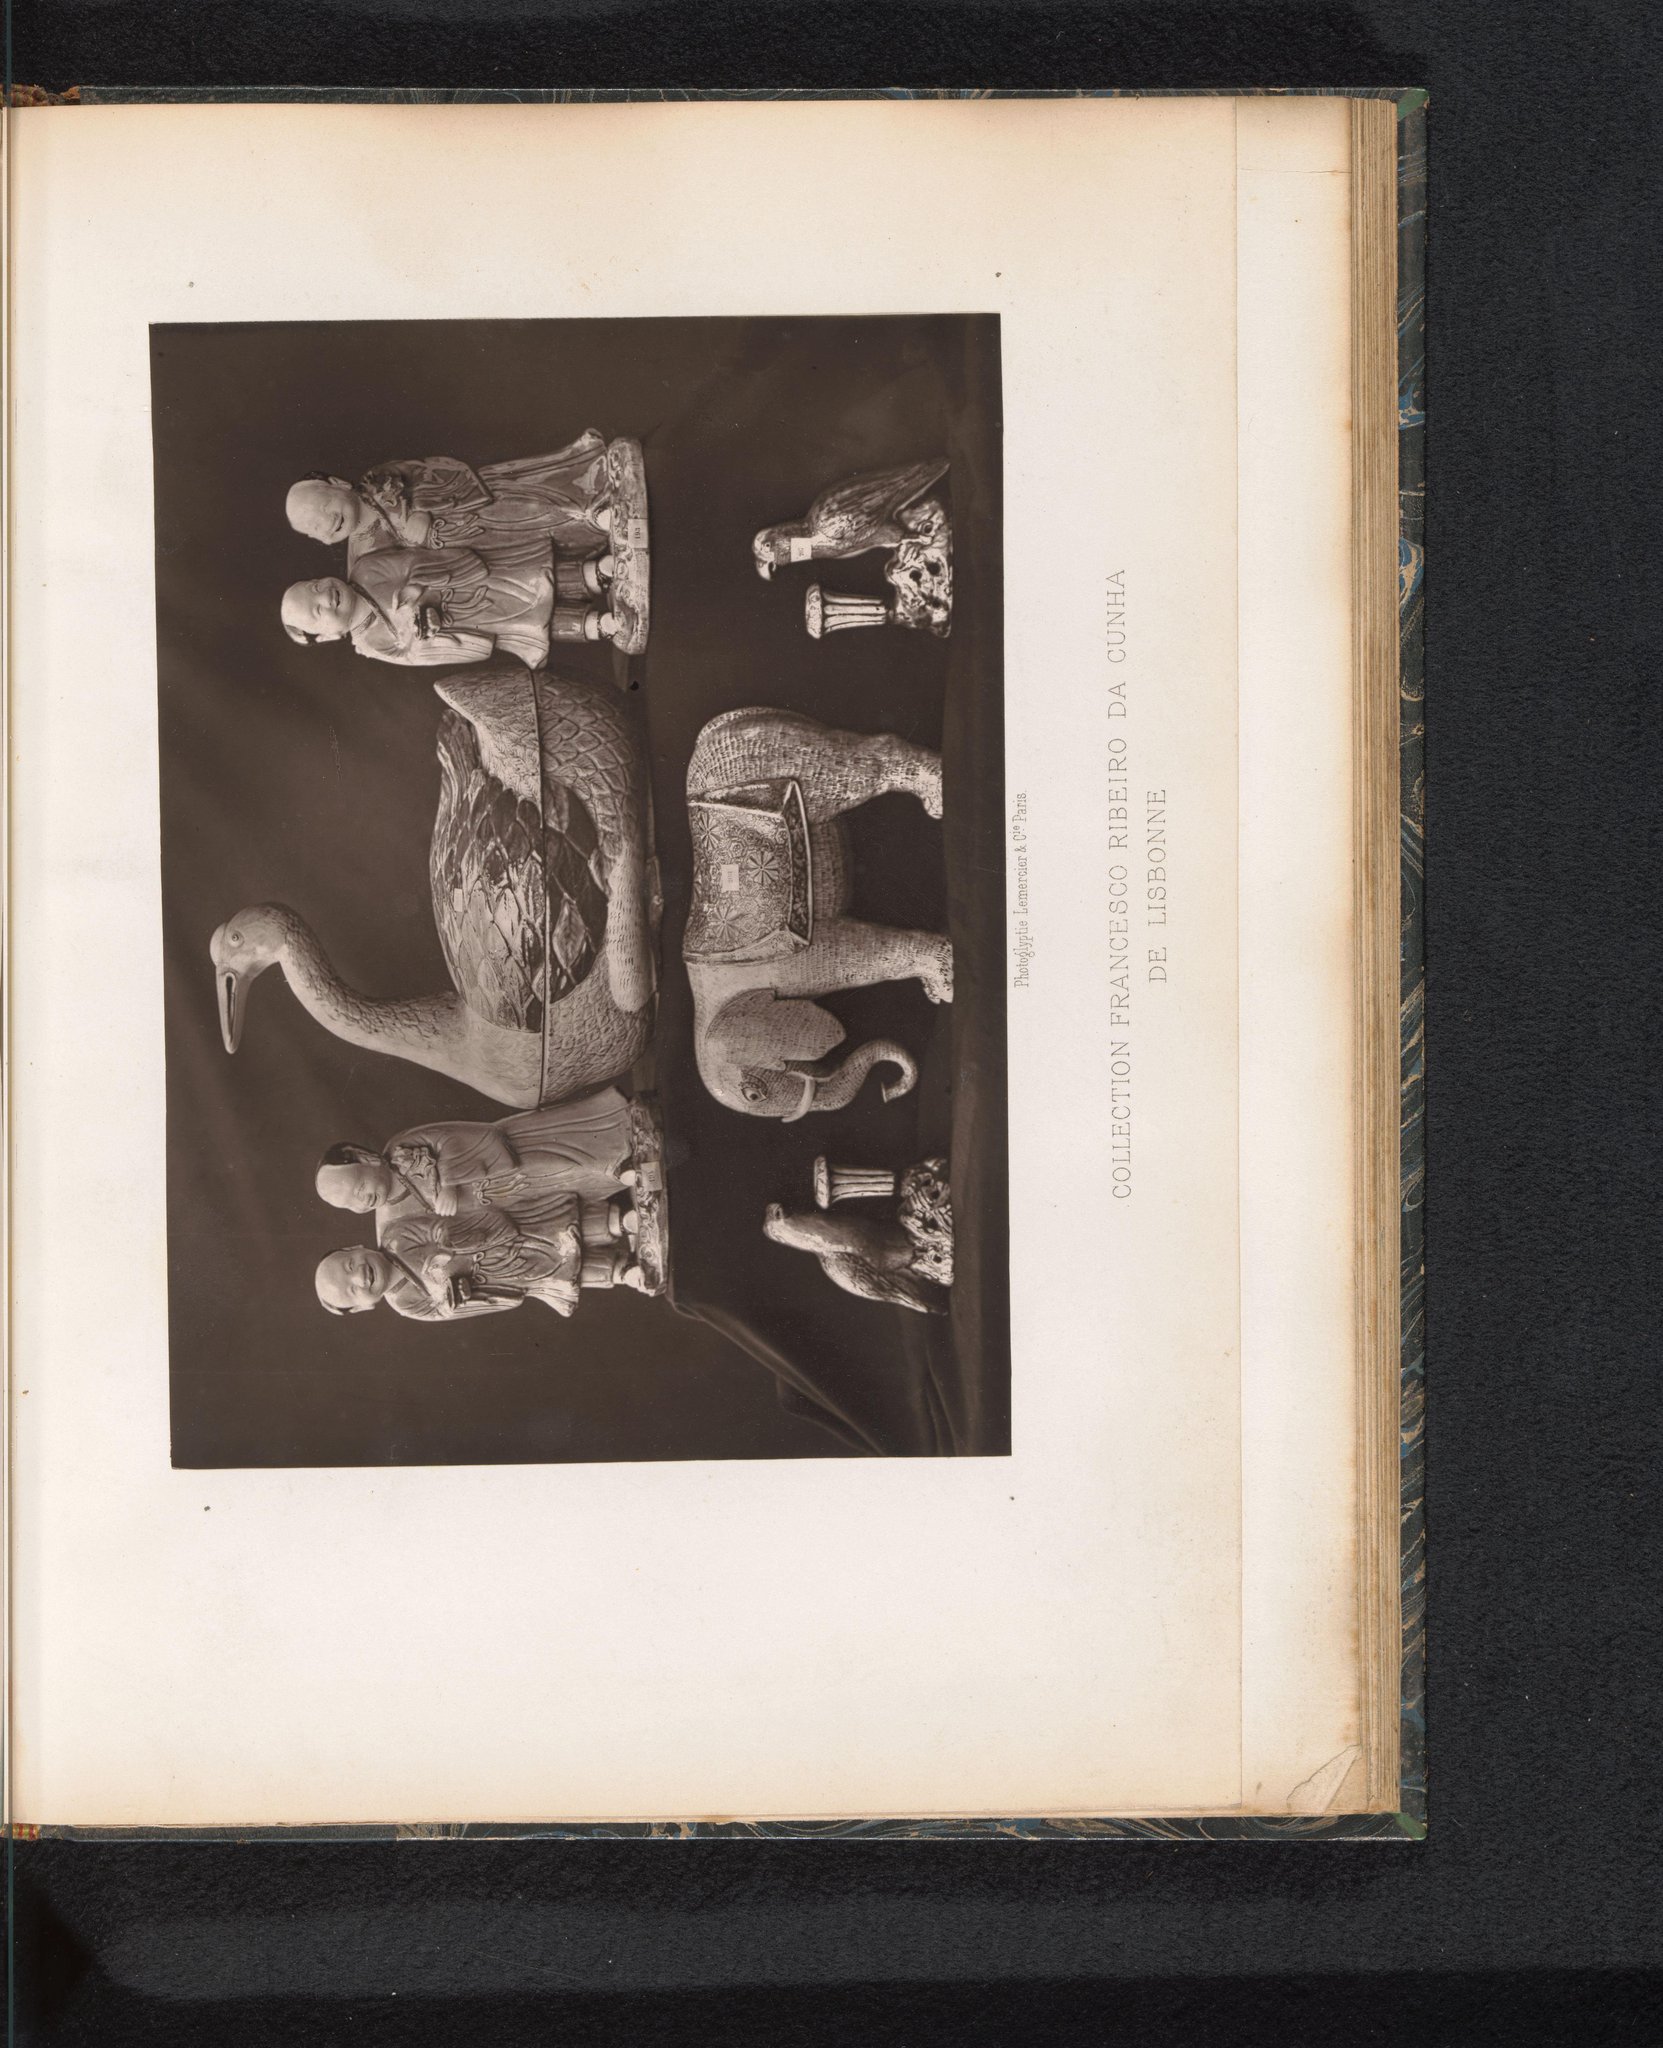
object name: page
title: Porseleinen beelden van een olifant, eend, twee papegaaien en twee koppels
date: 1879-1884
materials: paper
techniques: woodburytype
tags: ornamental birds: parrot, sculpture, trunked animals: elephant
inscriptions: inscription: ‘Collection Francesco Riberio da Cunha de Lisbonne’